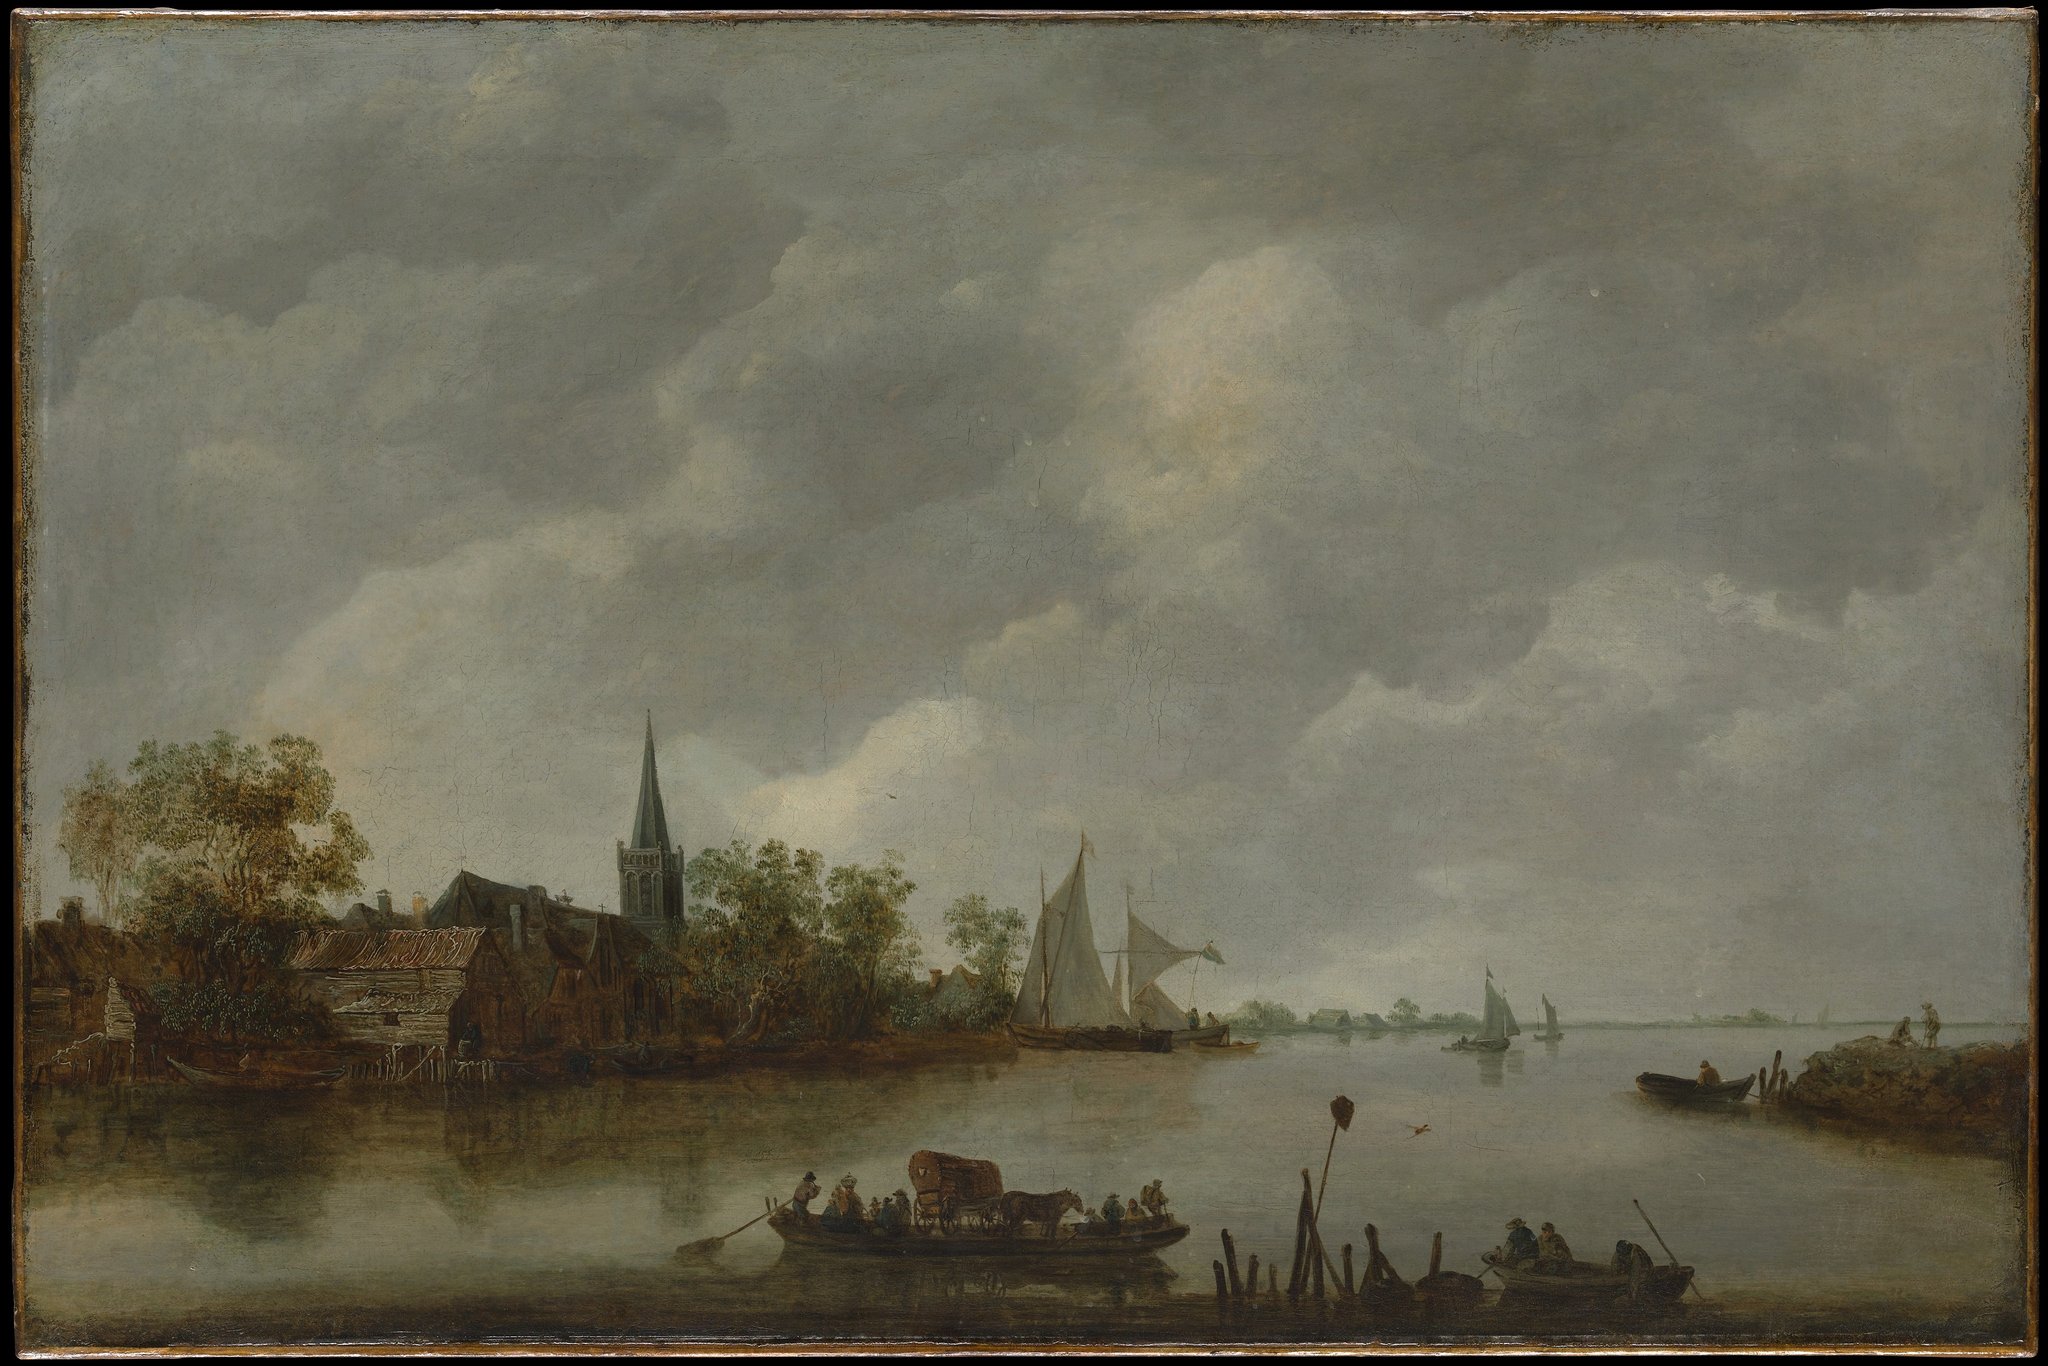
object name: painting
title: River View with a Village Church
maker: jan van goyen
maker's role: artist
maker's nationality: dutch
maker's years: 1596-1656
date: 1630-1669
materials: canvas, oil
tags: churches,rivers,boats